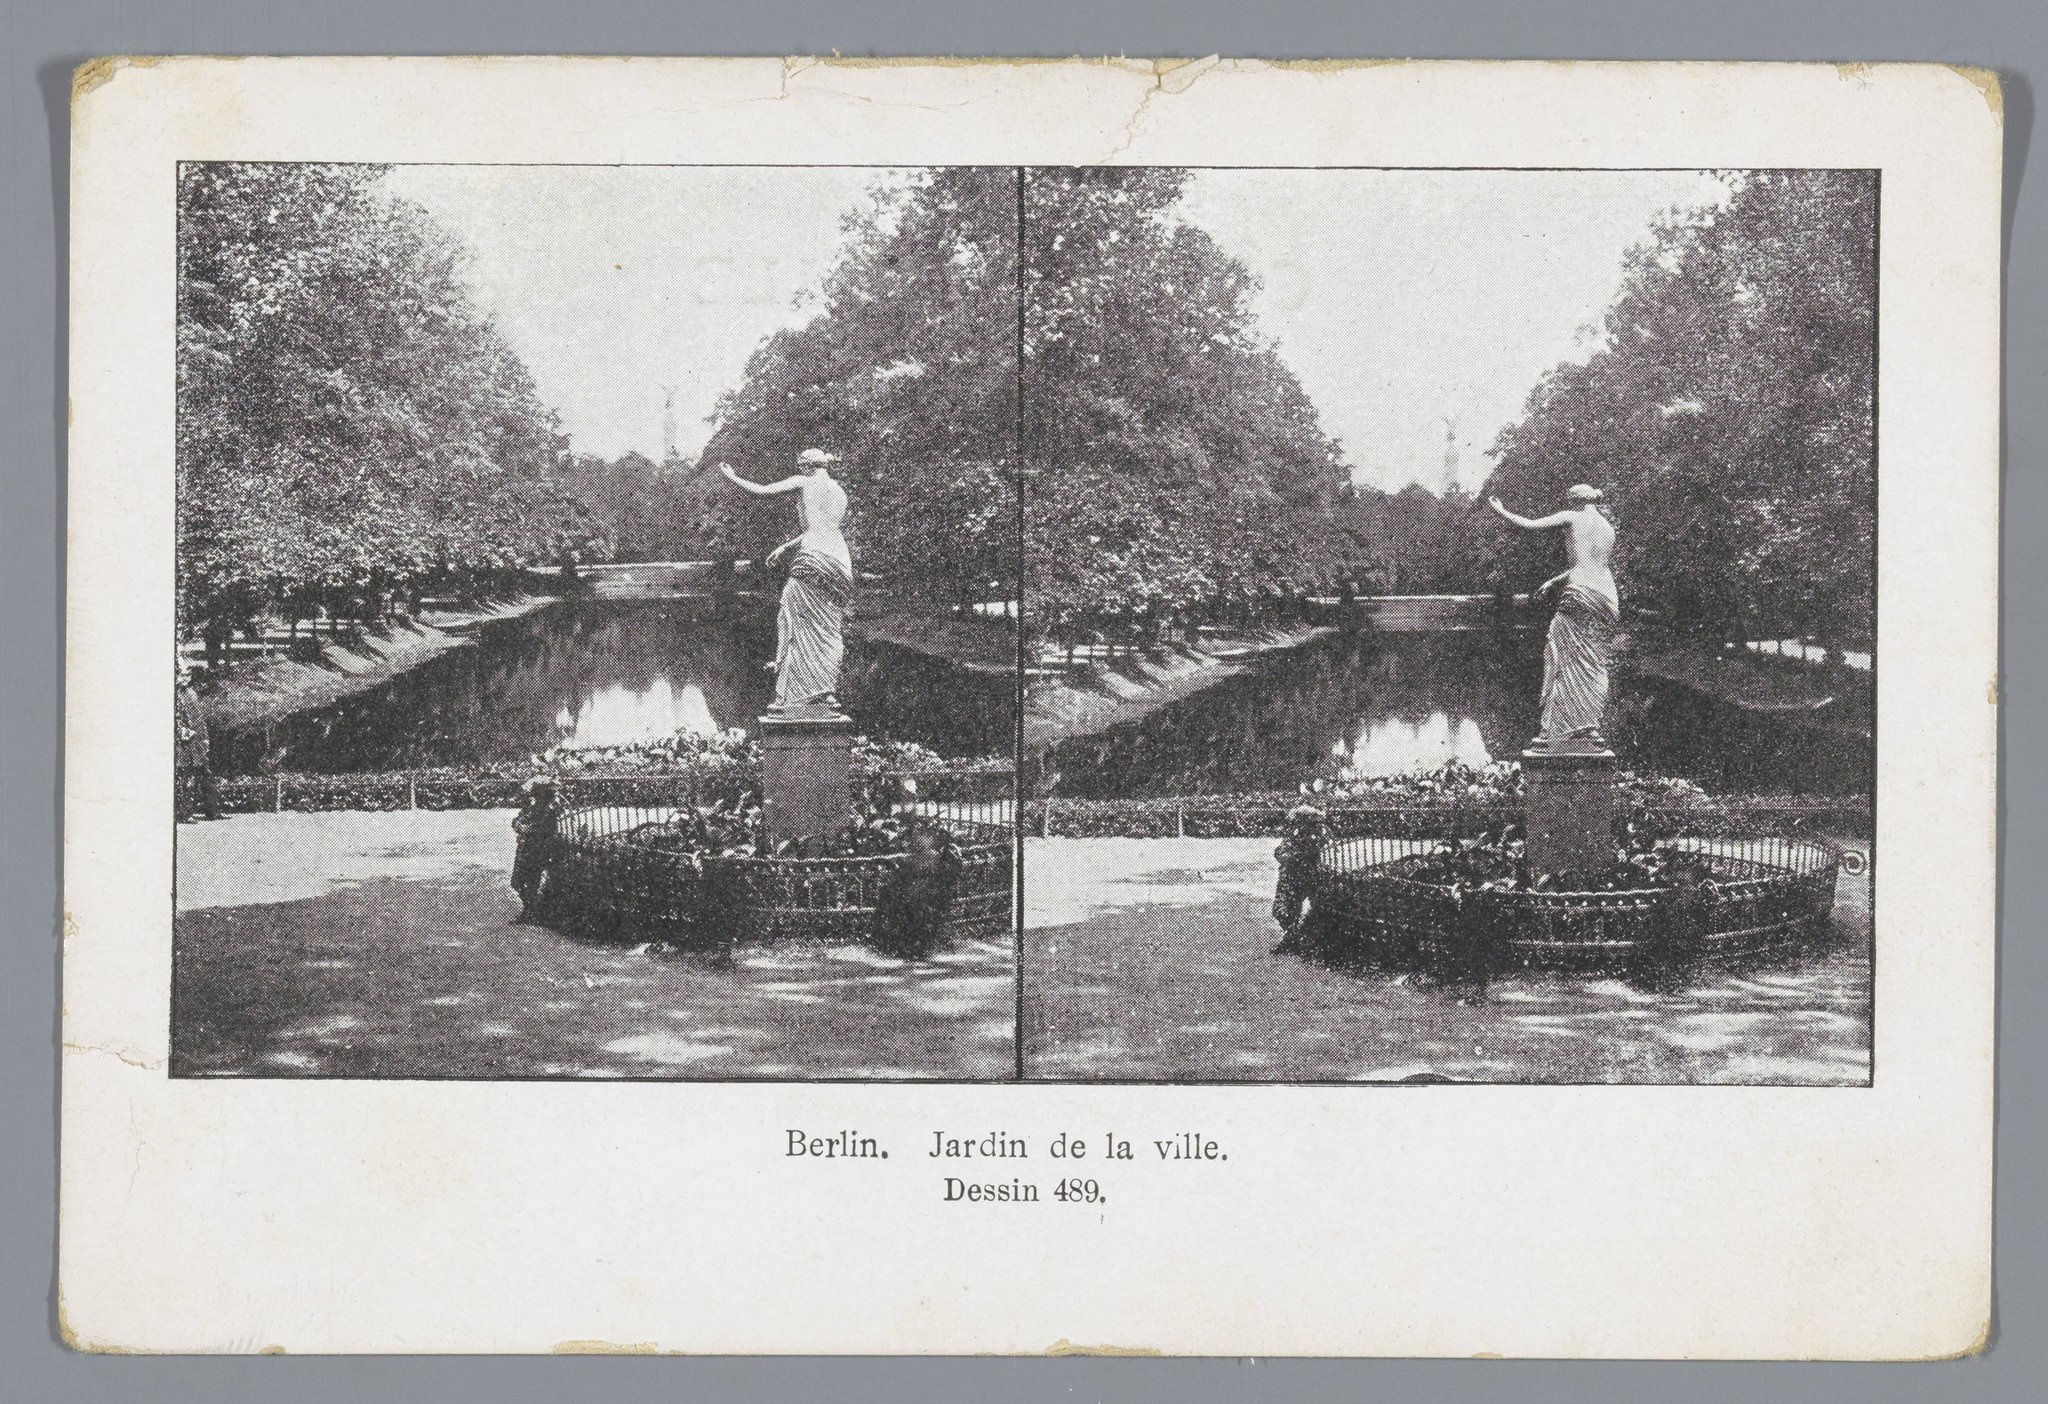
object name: stereograph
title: Berlin. Jardin de la ville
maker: Anonymous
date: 1890-1905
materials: cardboard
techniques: autotype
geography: europe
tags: public gardens, park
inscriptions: inscription: ‘Carte Postale (...)’, inscription: ‘Dessin 489.’